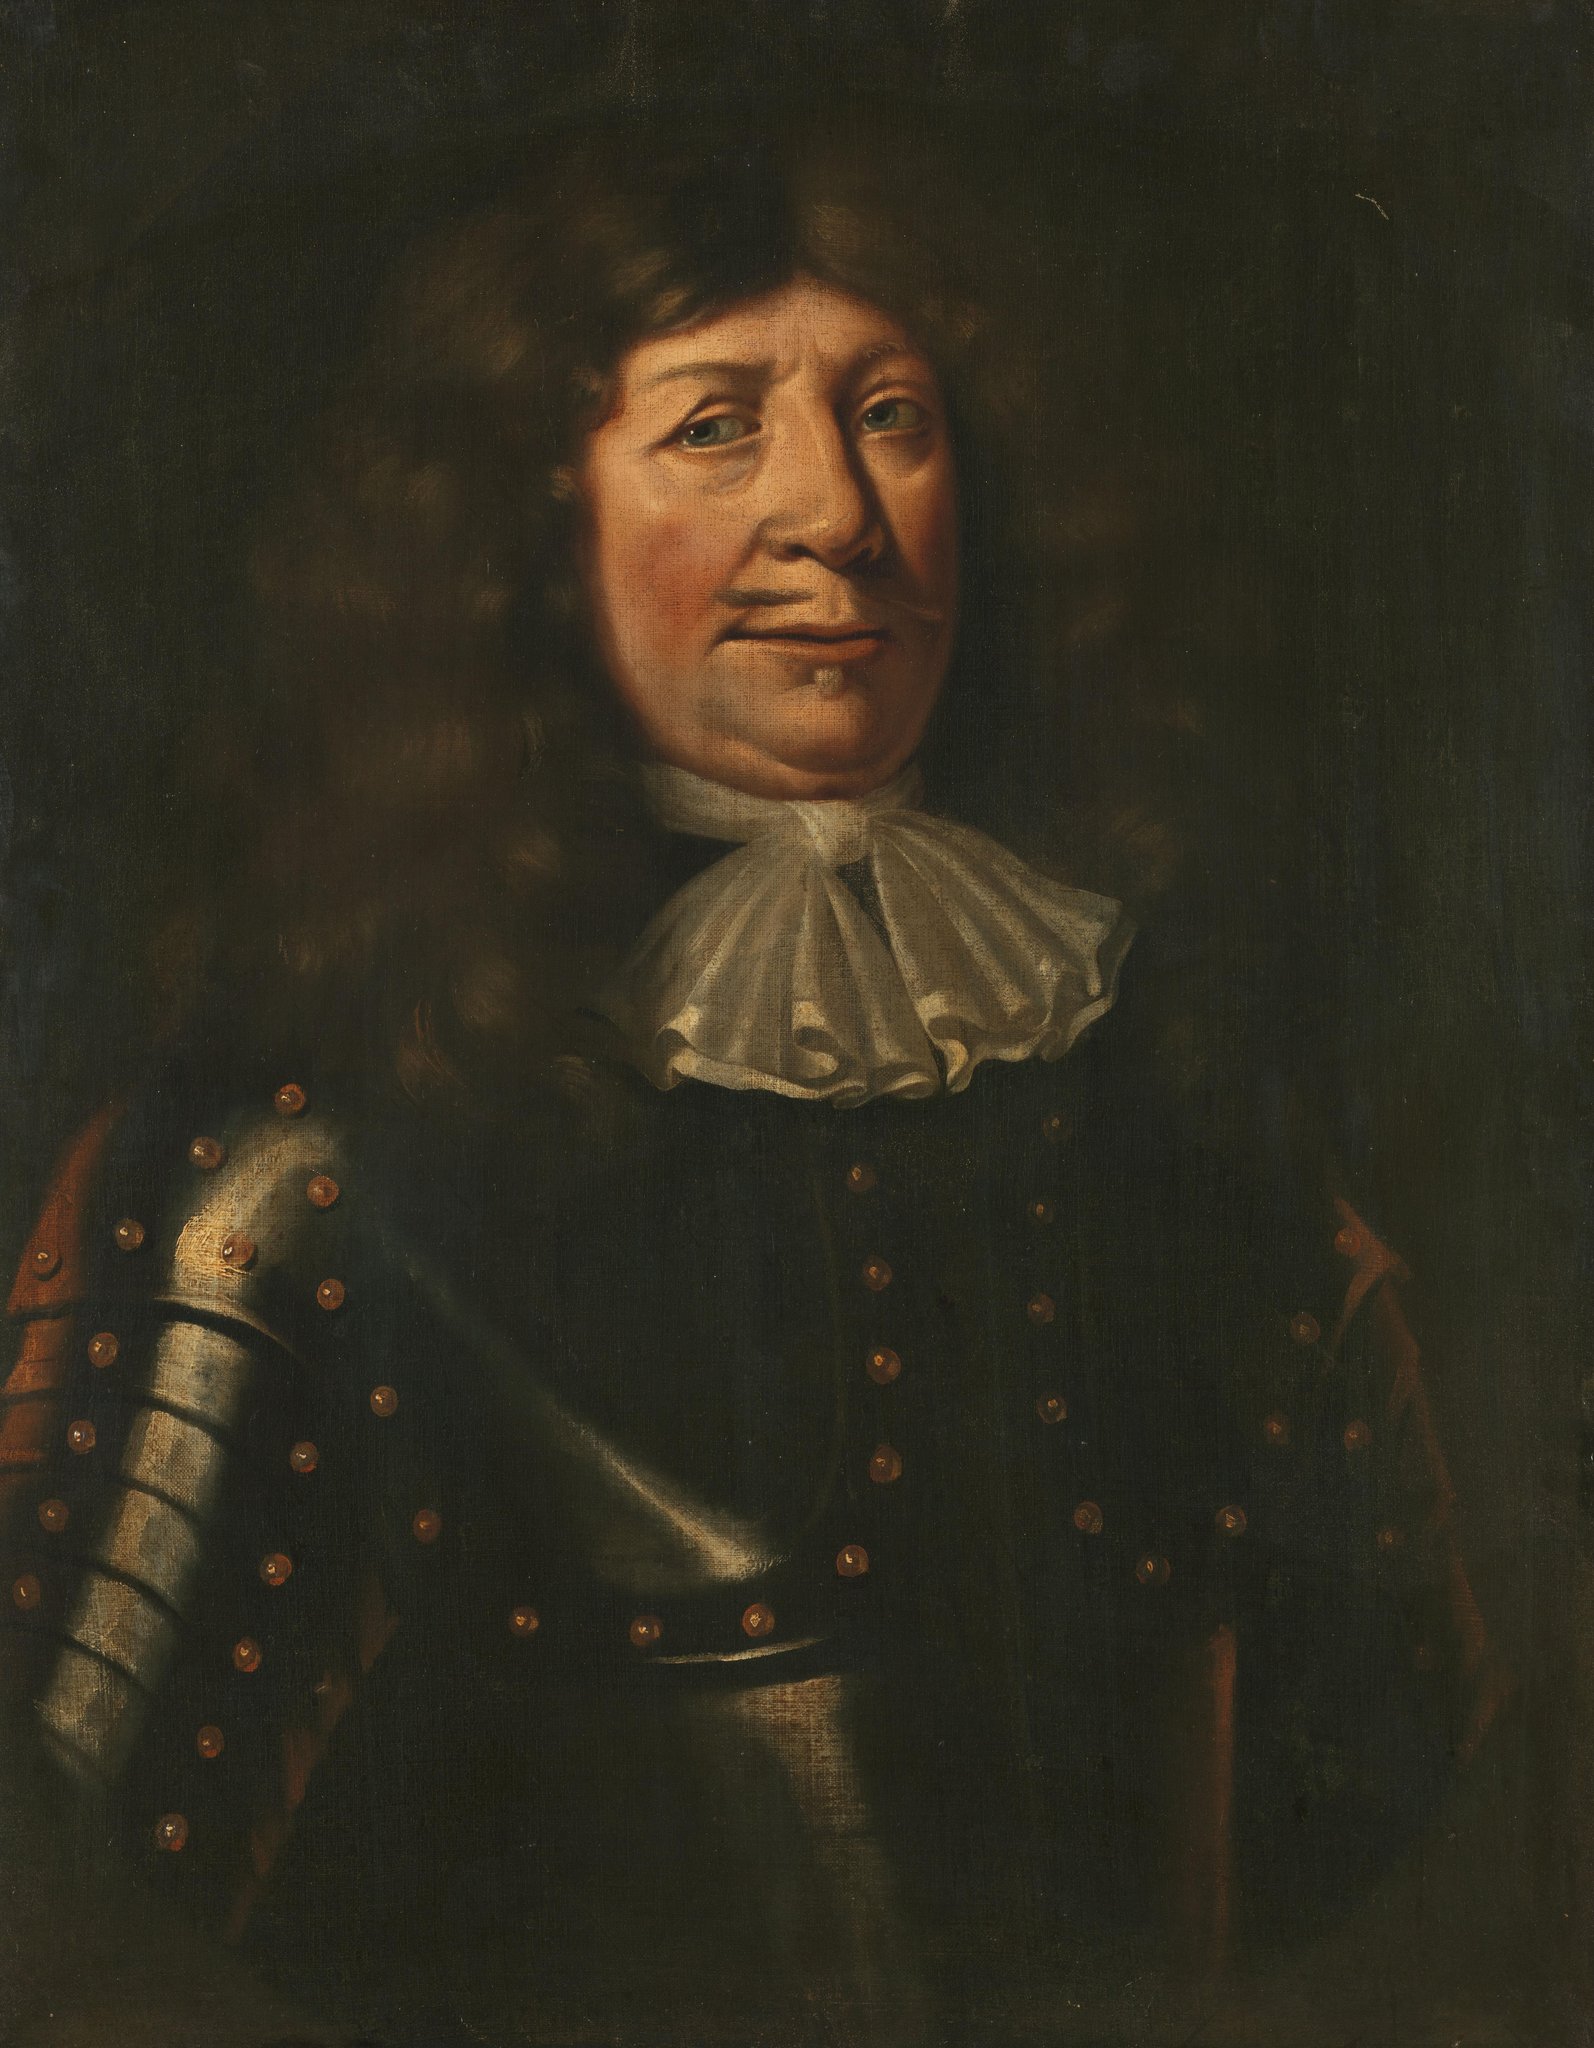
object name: painting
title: Portrait of Carel Rabenhaupt, Lieutenant-General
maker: Anonymous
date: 1670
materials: canvas, oil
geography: northern netherlands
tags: commander-in-chief, general, marshal, historical persons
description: Portret van Carel Rabenhaupt (1602-75). Luitenant-generaal, speelde een hoofdrol bij de verdediging van Groningen en de inname van Coevorden (1672). Buste, in wapenrusting, naar rechts.